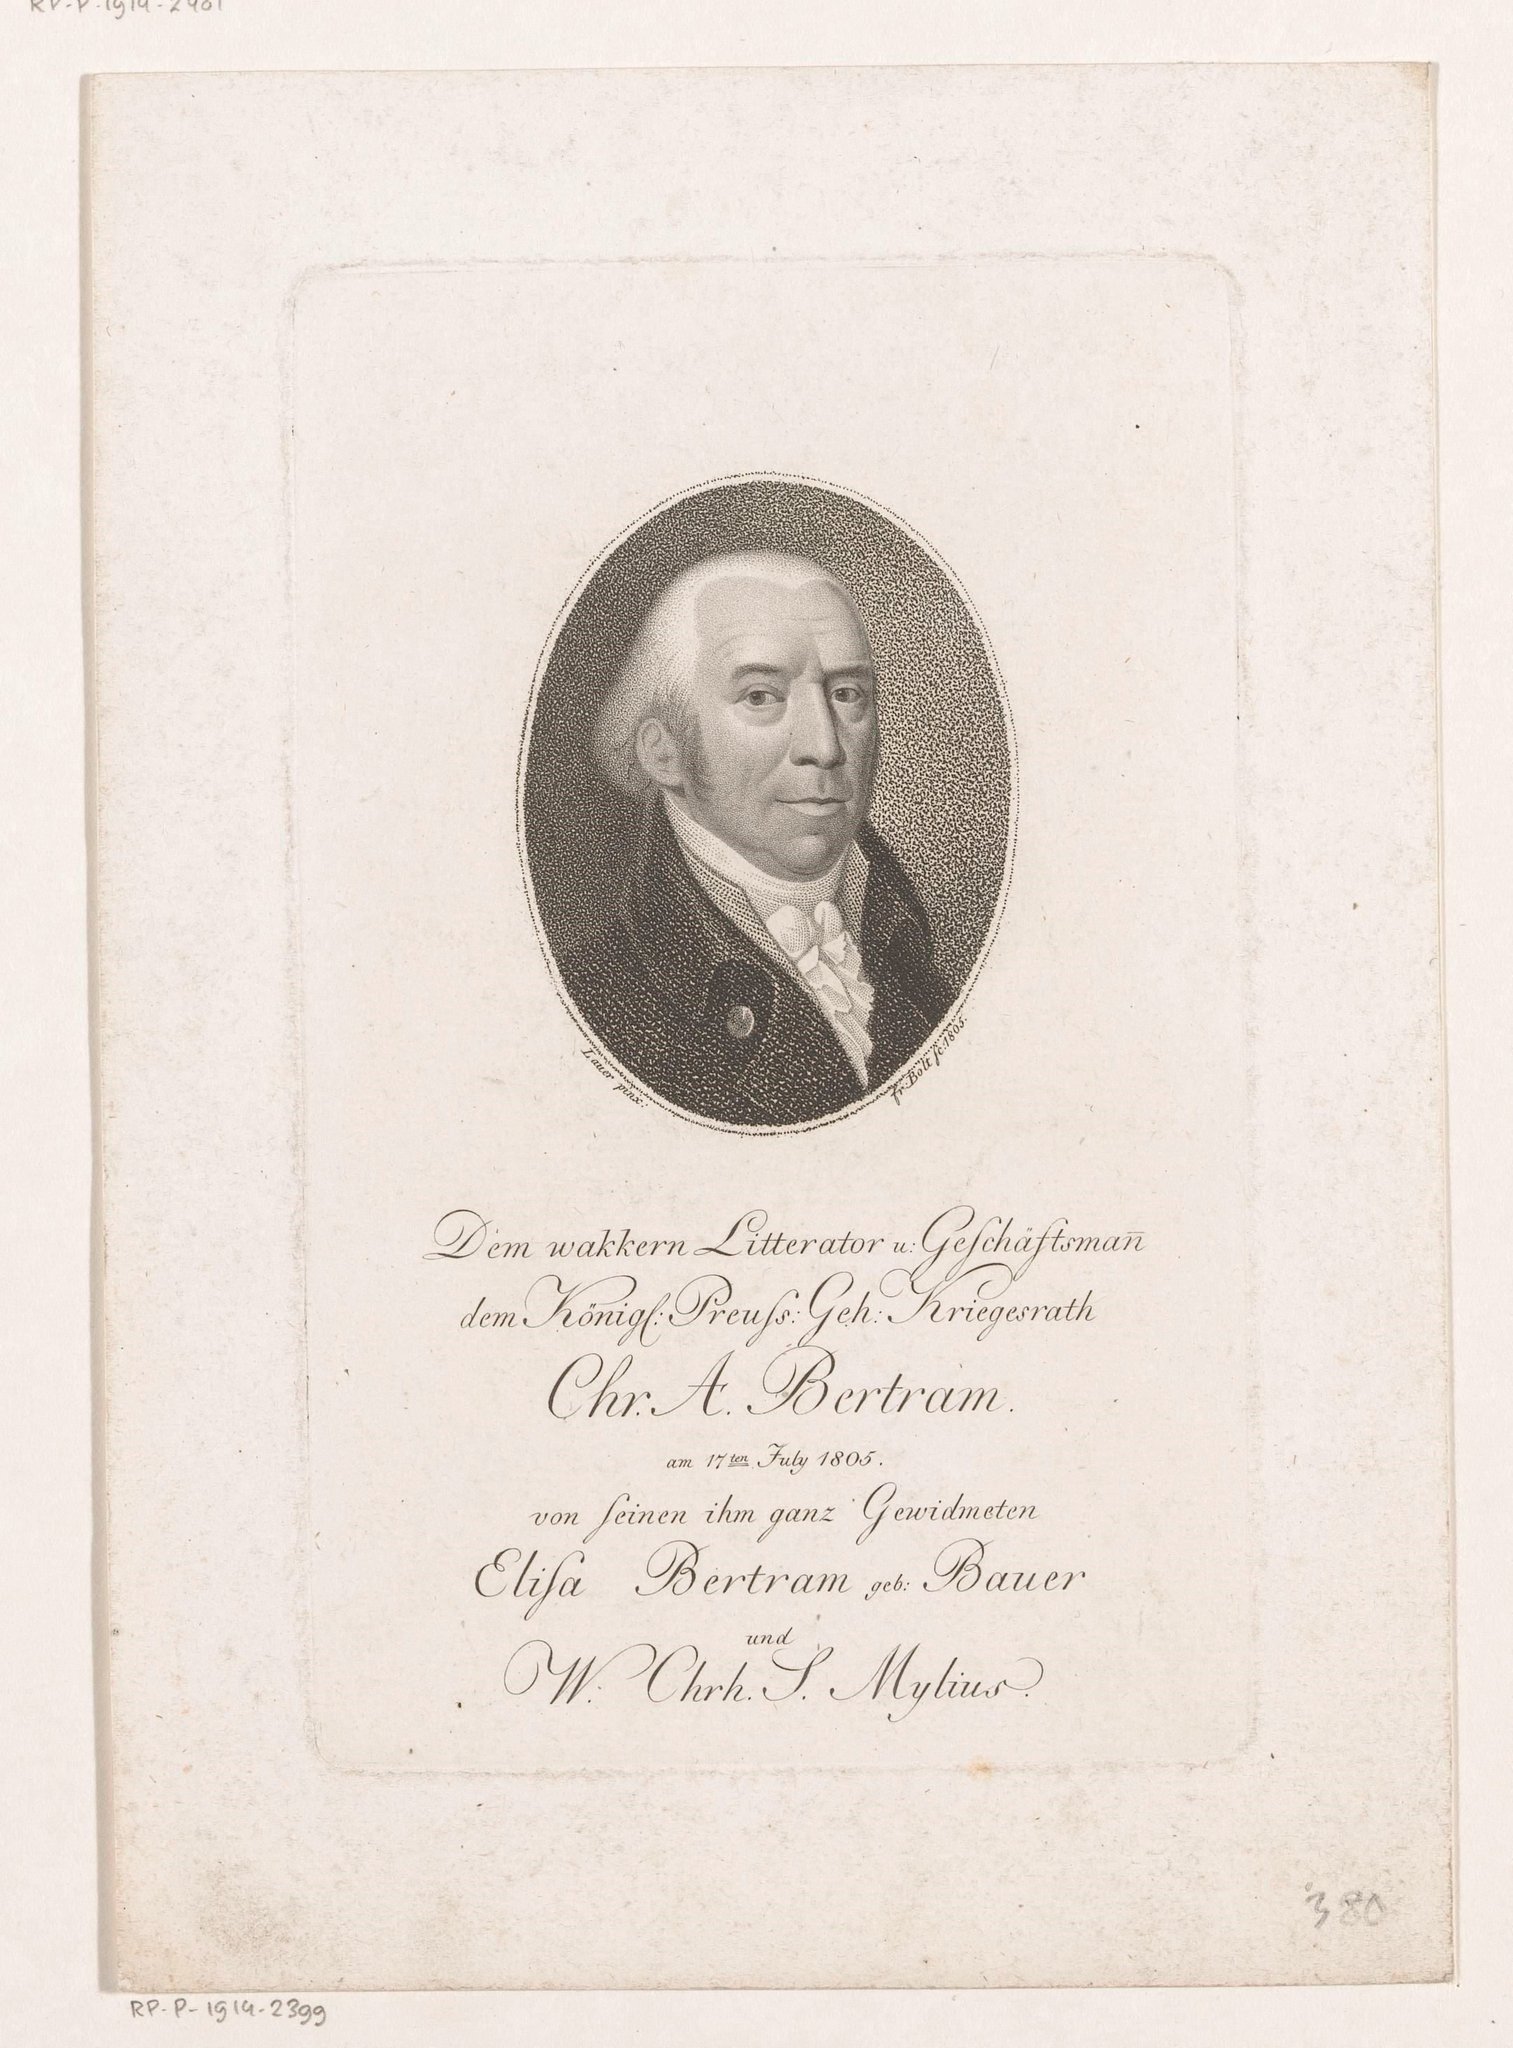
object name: print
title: Portret van Christian August Bertram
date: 1805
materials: paper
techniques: stippling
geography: berlin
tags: christian august bertram, historical persons, portrait of a writer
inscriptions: collector's mark: Lugt 2228